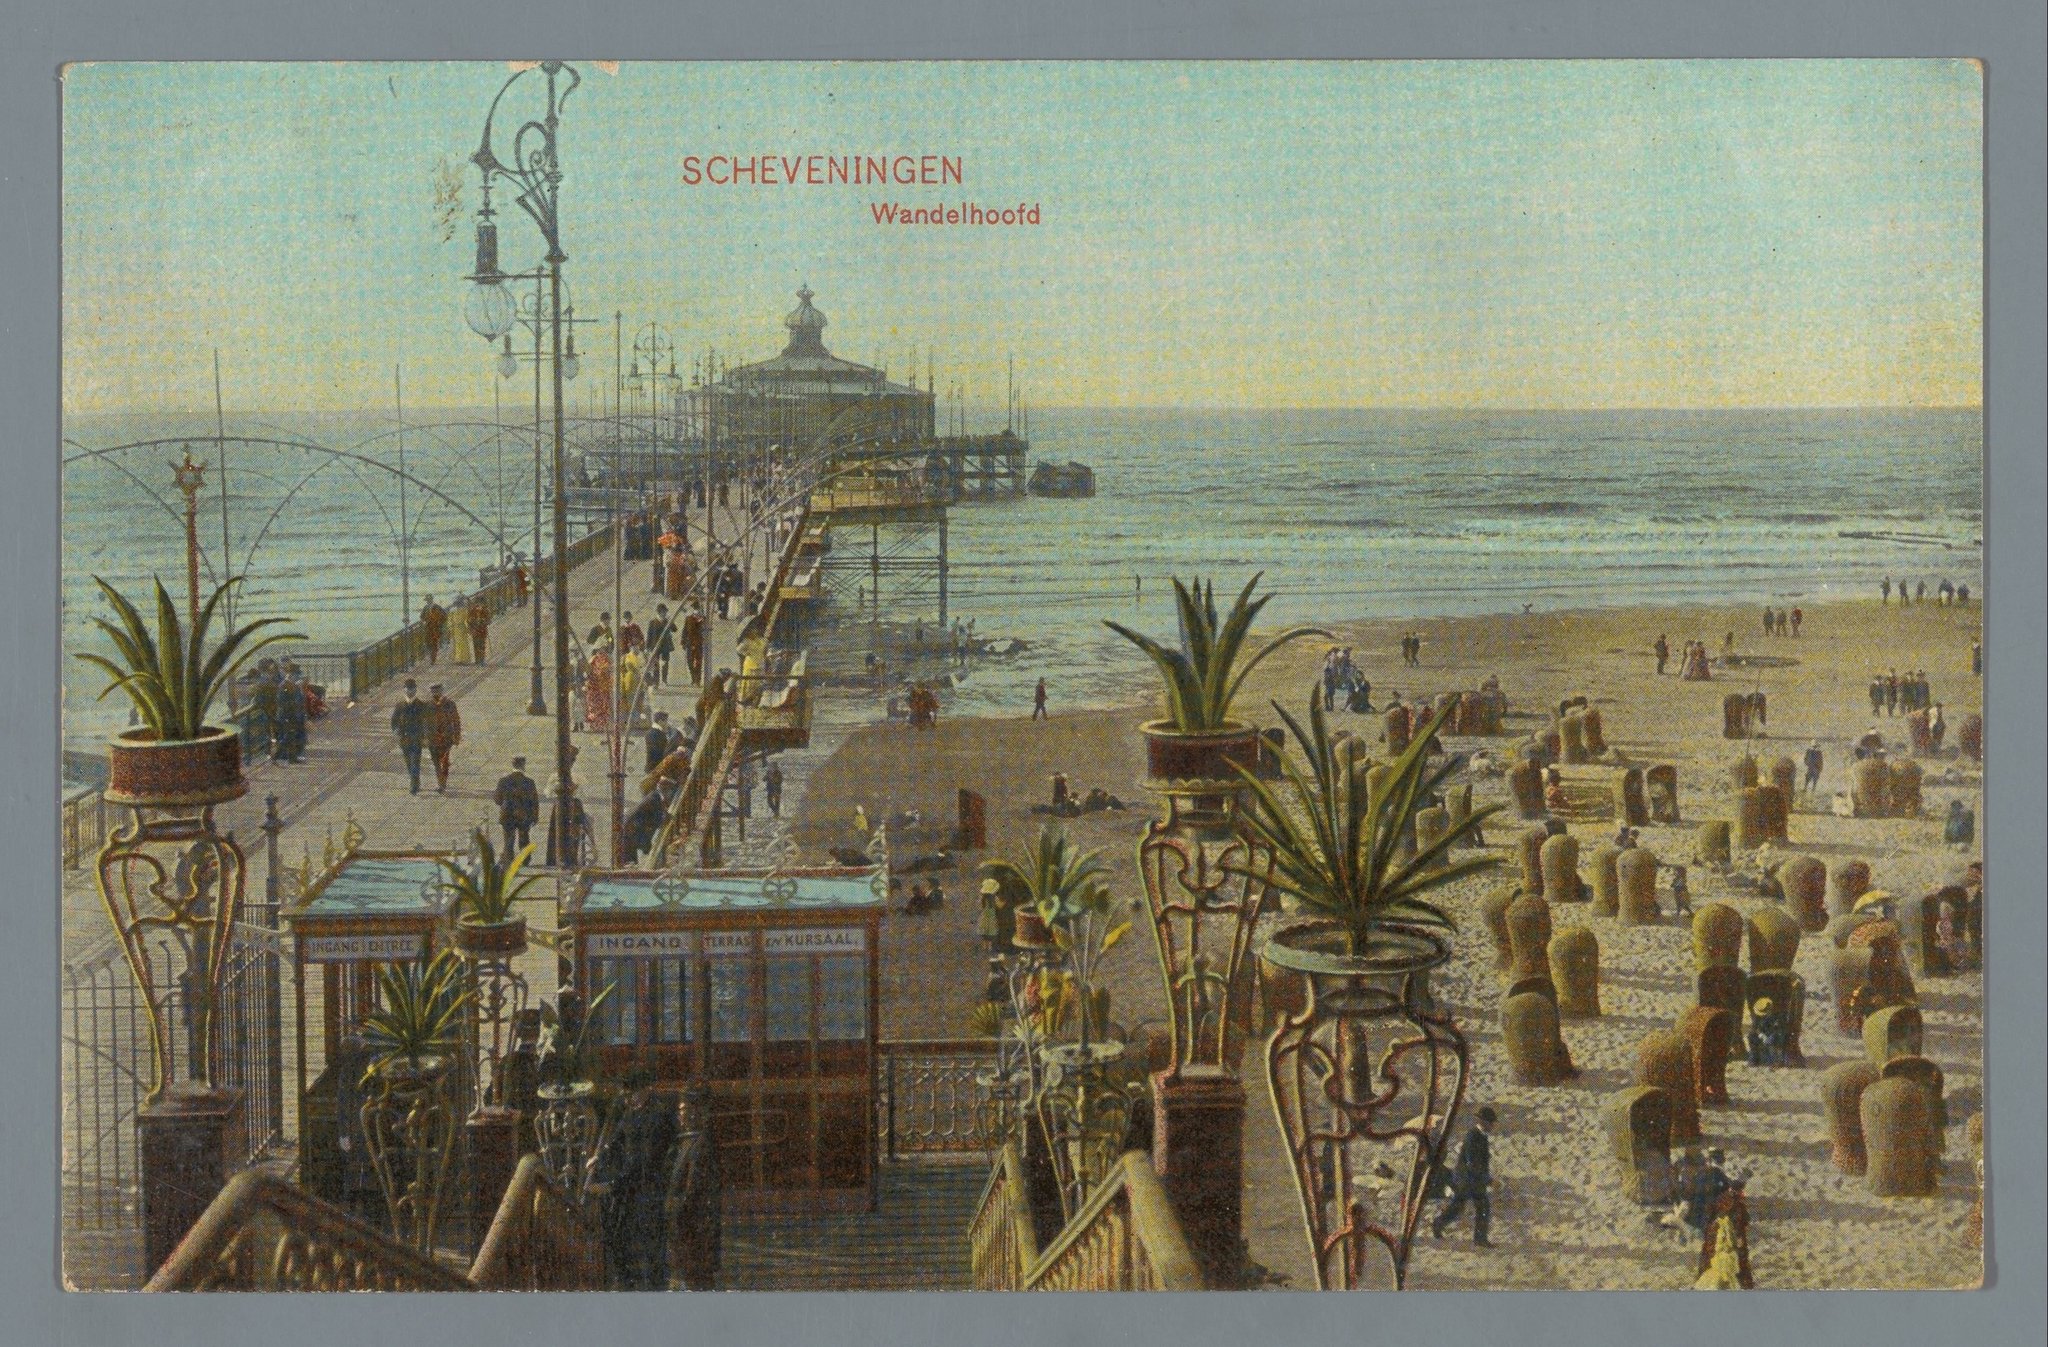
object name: ansichtkaart, prentbriefkaart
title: Scheveningen, Wandelhoofd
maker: Anonymous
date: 1917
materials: cardboard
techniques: writing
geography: scheveningen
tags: coast